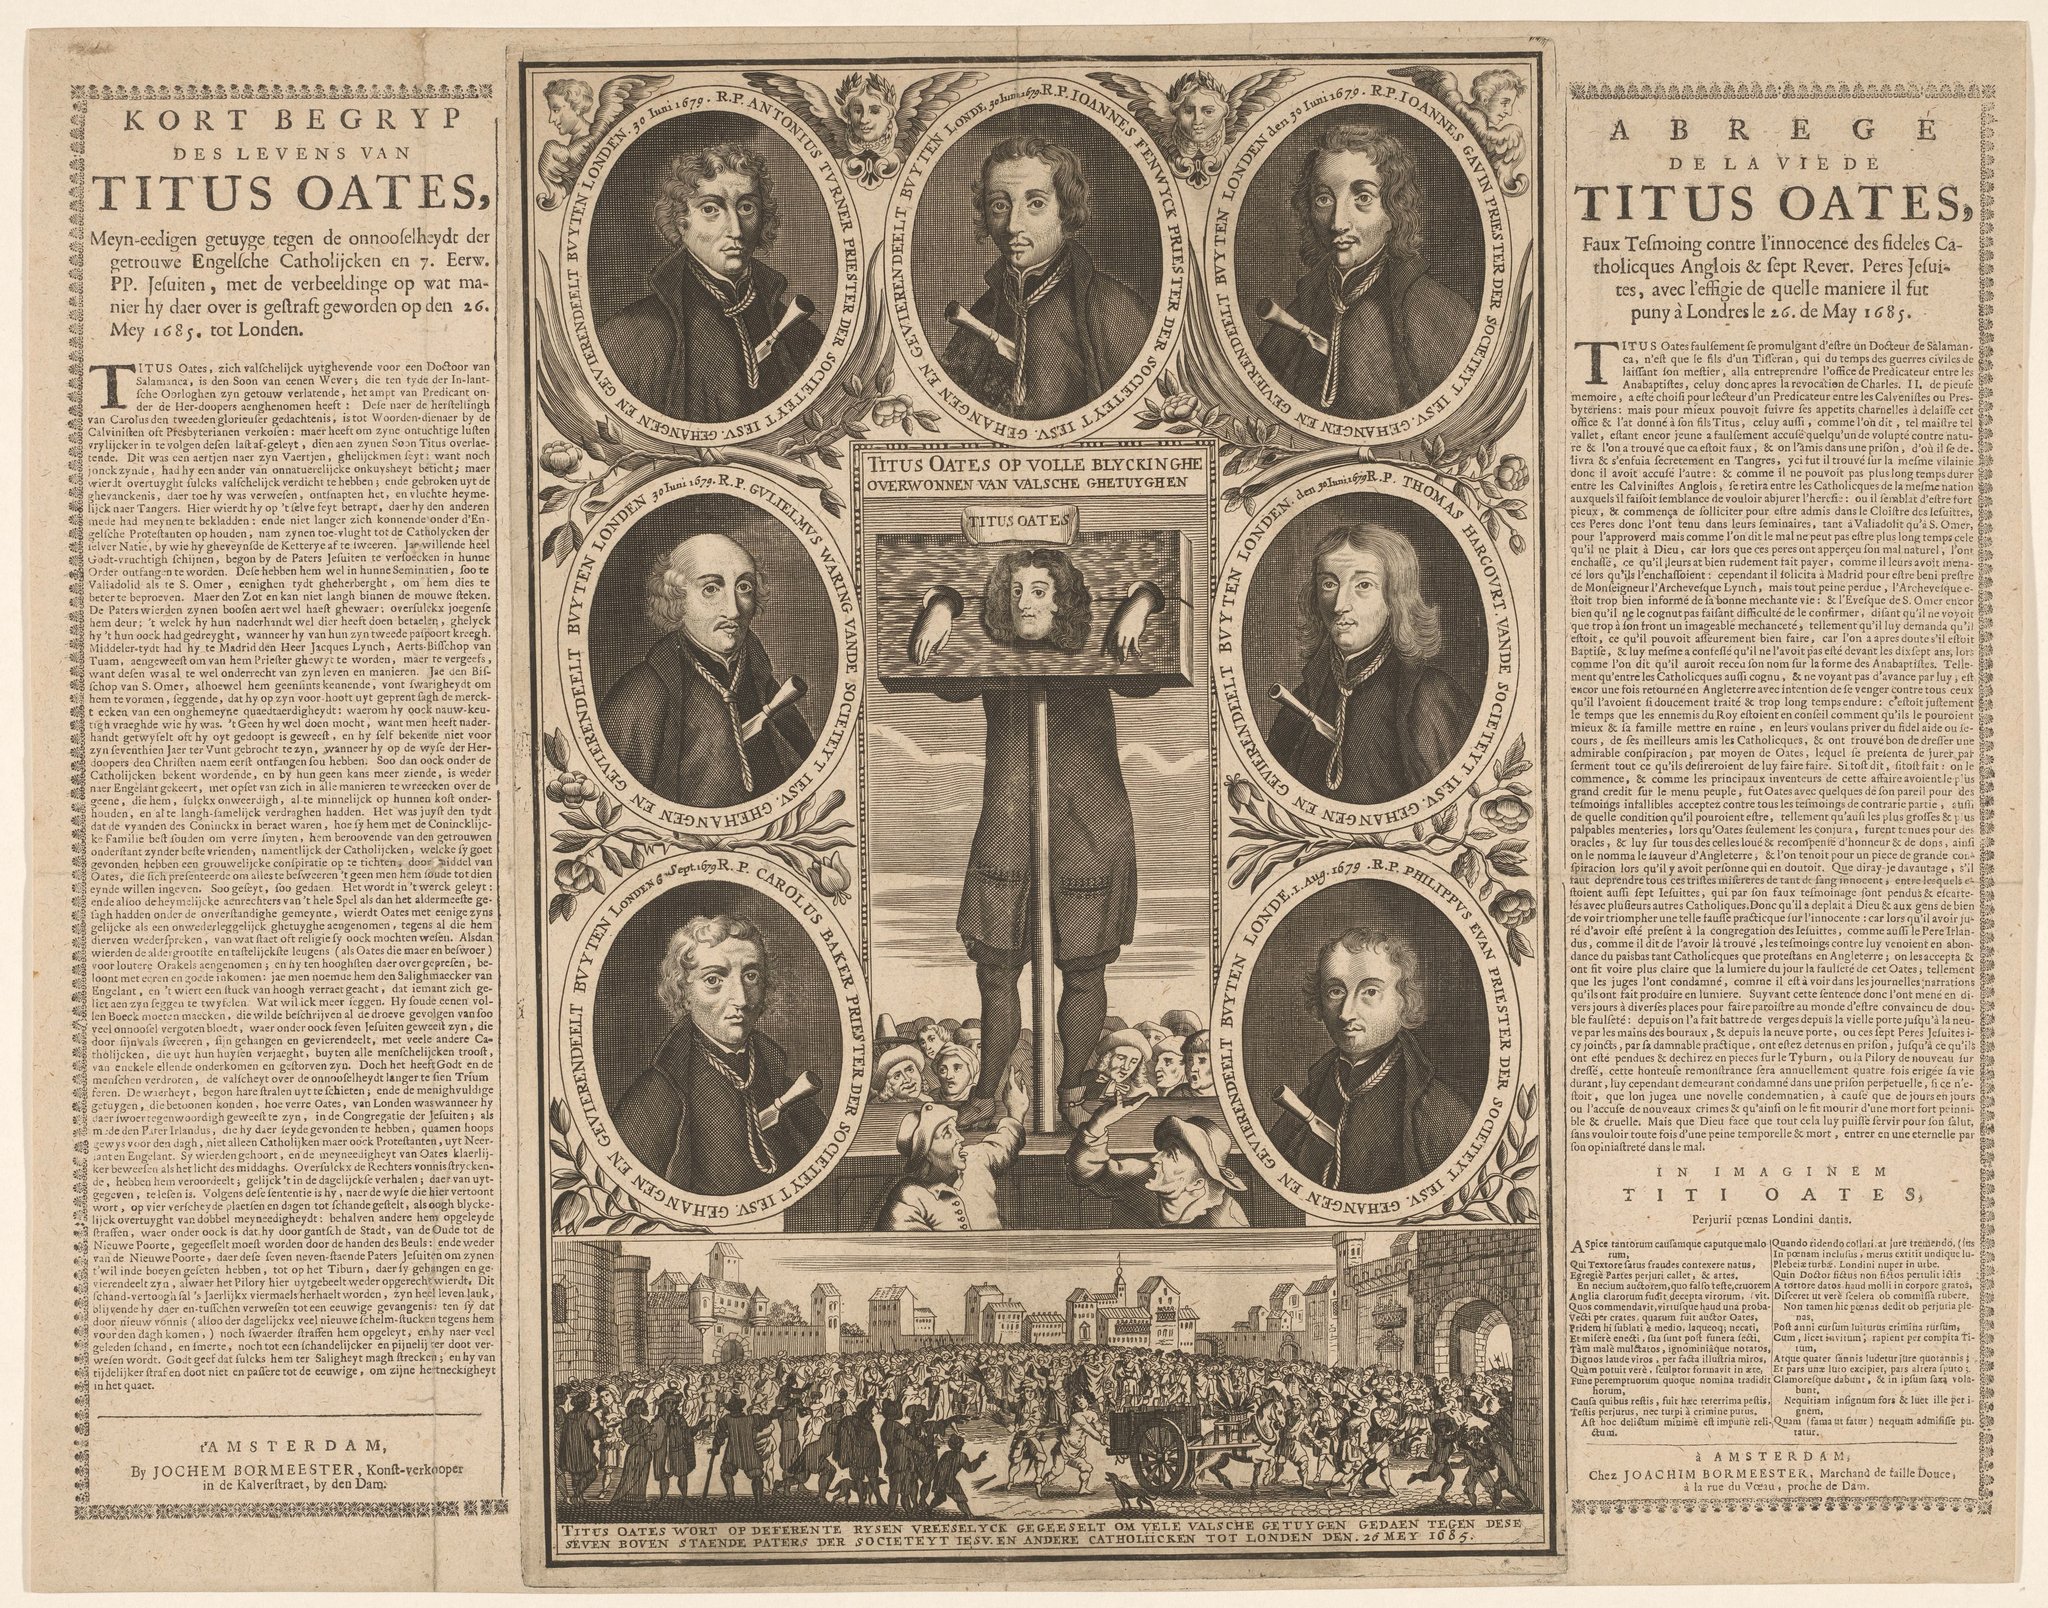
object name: print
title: Kort Begryp Des Levens Van Titus Oates / Abrege De La Vie De Titus Oates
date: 1685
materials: paper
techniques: engraving, etching, letterpress printing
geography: amsterdam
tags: priest, karel ii (koning van engeland), in the pillory, in the stocks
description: De bedrieger Titus Oates aan de schandpaal, 26 mei 1685. Blad met een voorstelling van Oates aan de schandpaal omgeven door de portretten van de zeven jezuïeten die door hem valselijk waren beschuldigd en terechtgesteld in 1679. Oates beschuldigde katholieken van het beramen van een komplot tegen koning Karel II, de zogenaamde Popish Plot. Onderaan is te zien hoe Oates vastgebonden aan een kar in het openbaar wordt gegeseld. Links en rechts beschrijvingen in het Nederlands en Frans.